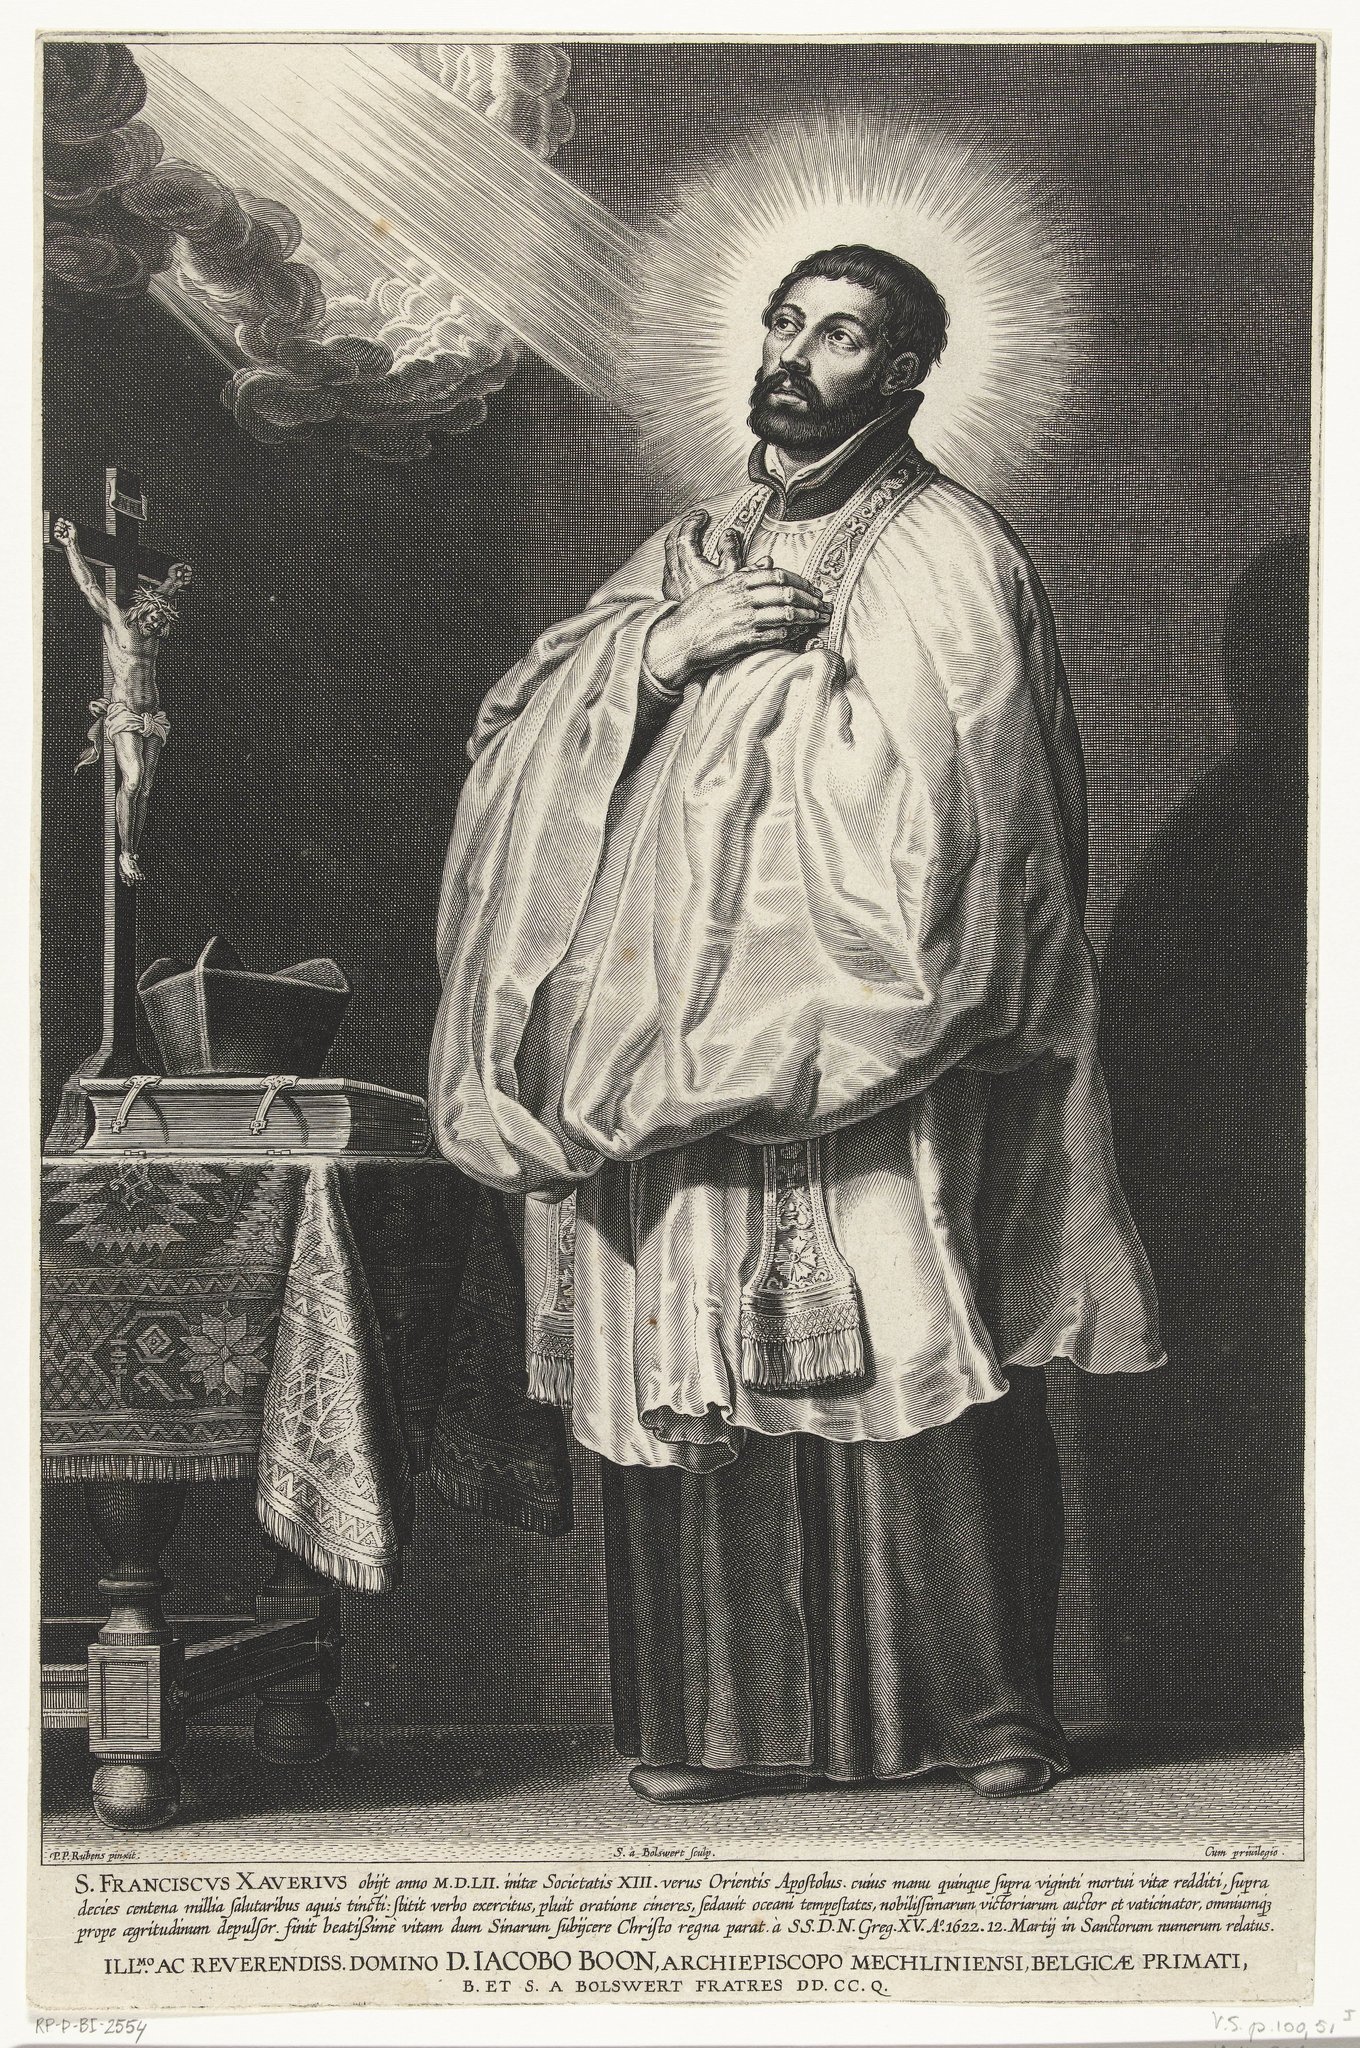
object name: print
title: S. Franciscvs Xaverivs (...) Sanctorum numerum relatus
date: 1622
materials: paper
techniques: engraving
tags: the jesuit missionary francis xavier; possible attributes: cross, crucifix, flaming heart, indian, lily, torch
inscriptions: collector's mark: Lugt 2228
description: Prent naar schilderij van Peter Paul Rubens.